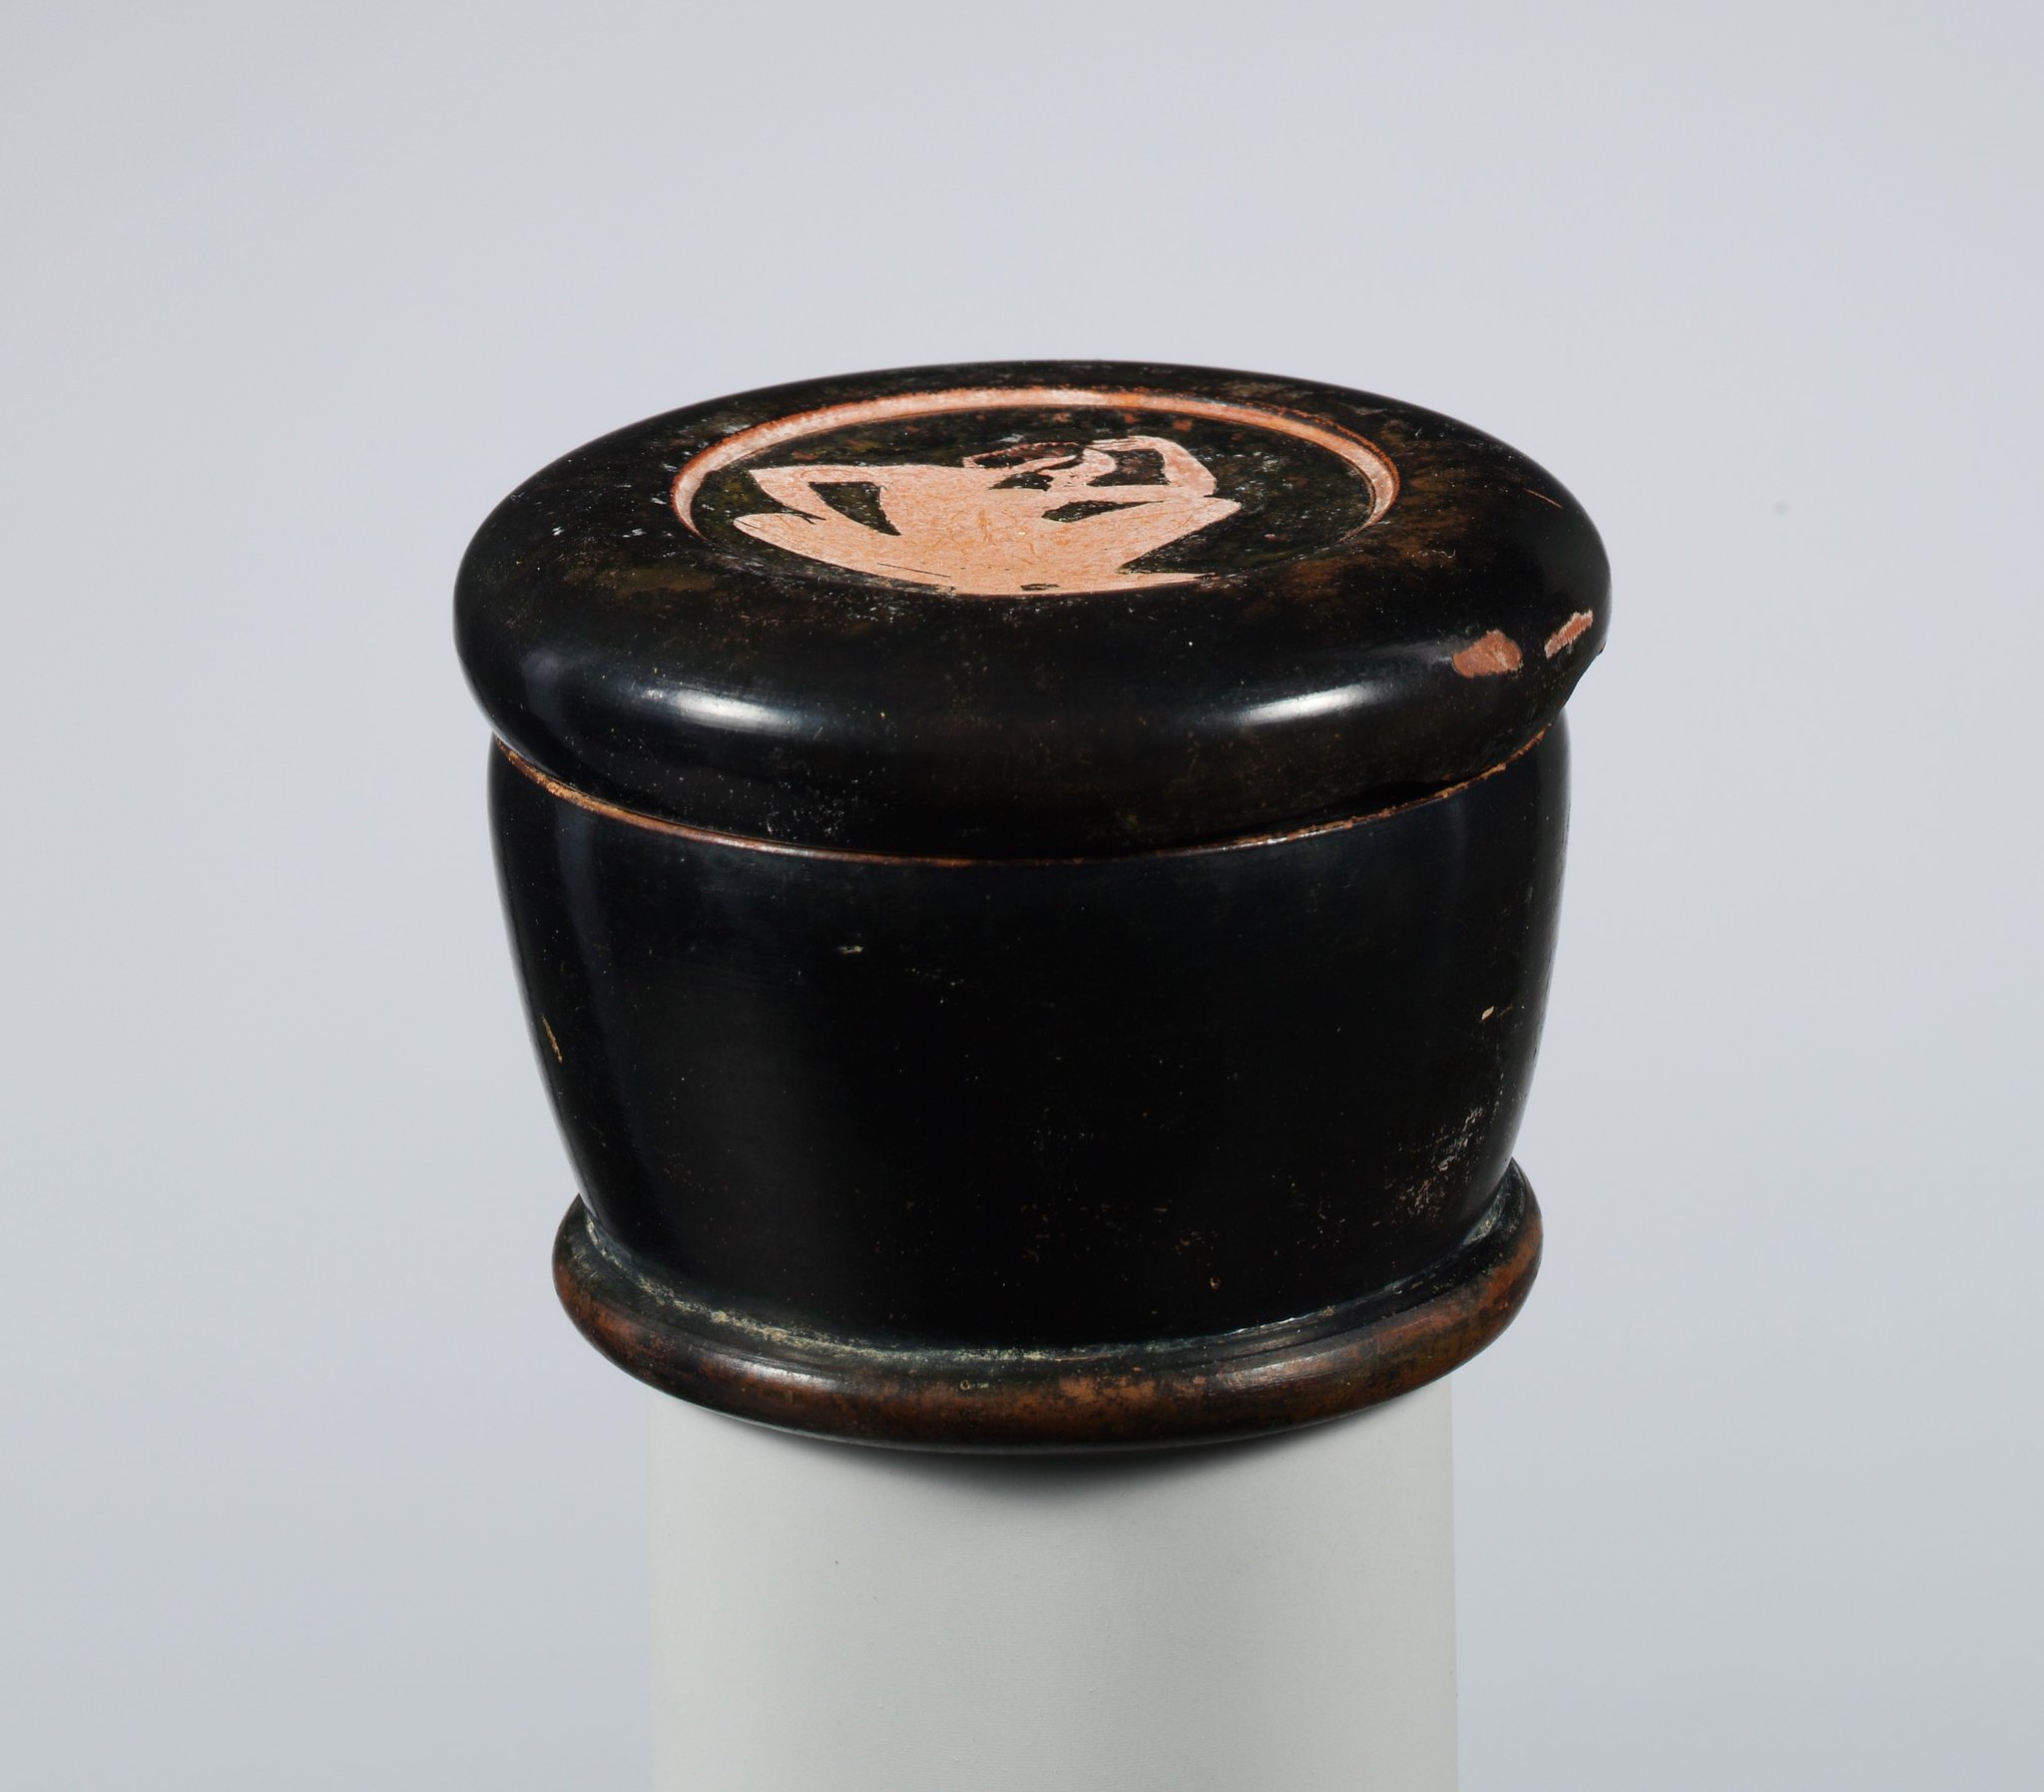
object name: pyxis, type d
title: Terracotta pyxis (box)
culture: greek, attic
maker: thaliarchos painter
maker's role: artist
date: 510 BCE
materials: terracotta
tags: satyrs